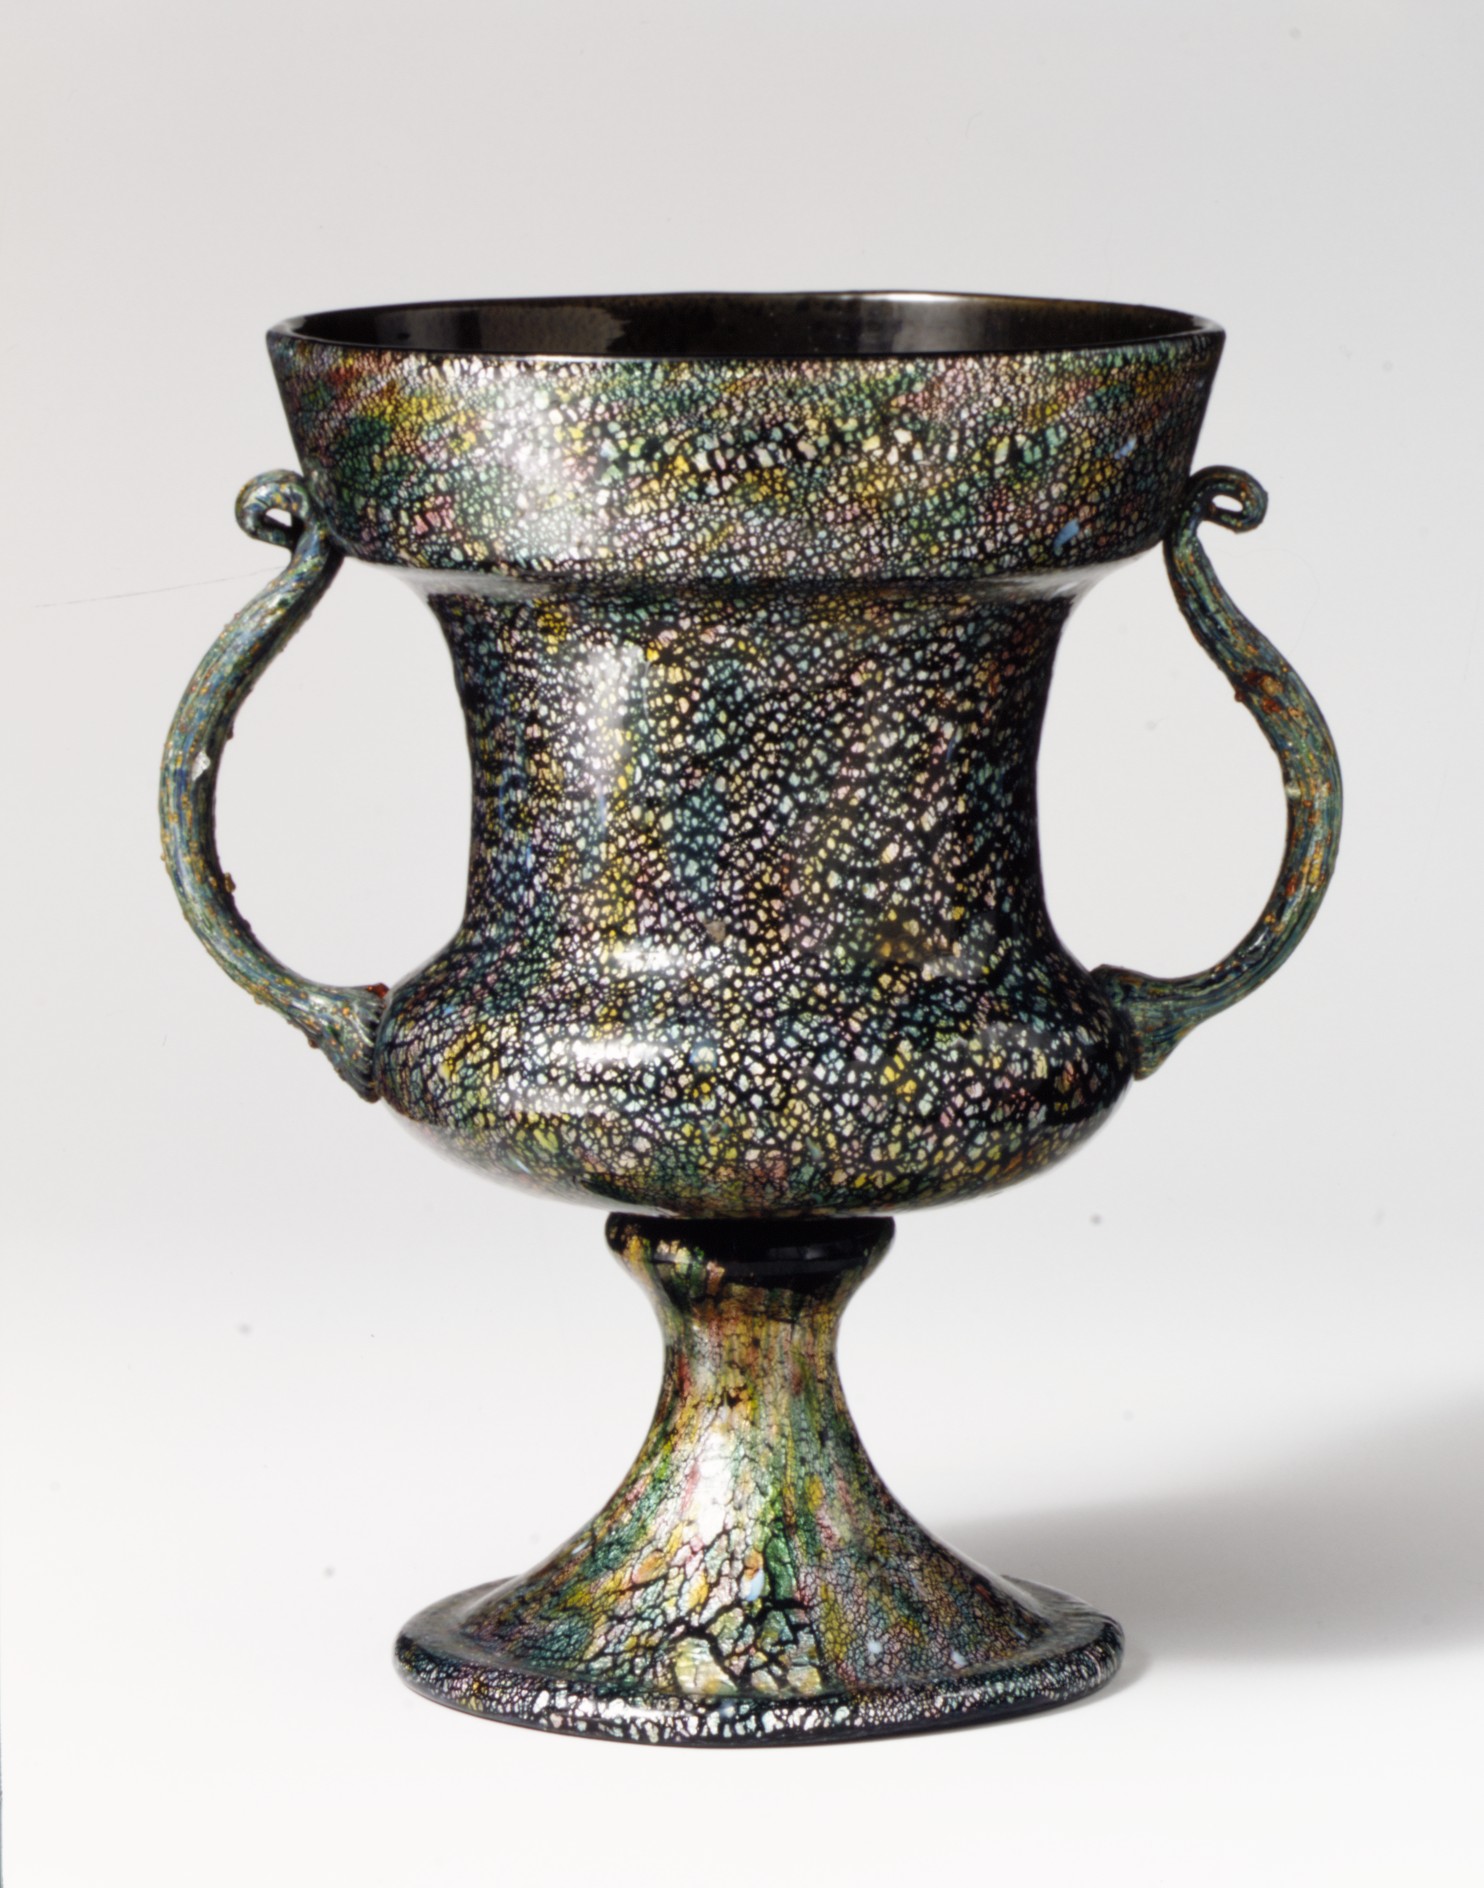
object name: cup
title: Olive glass cup with iridescent effect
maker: barovier family glasshouse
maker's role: maker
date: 1801-1900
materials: glass